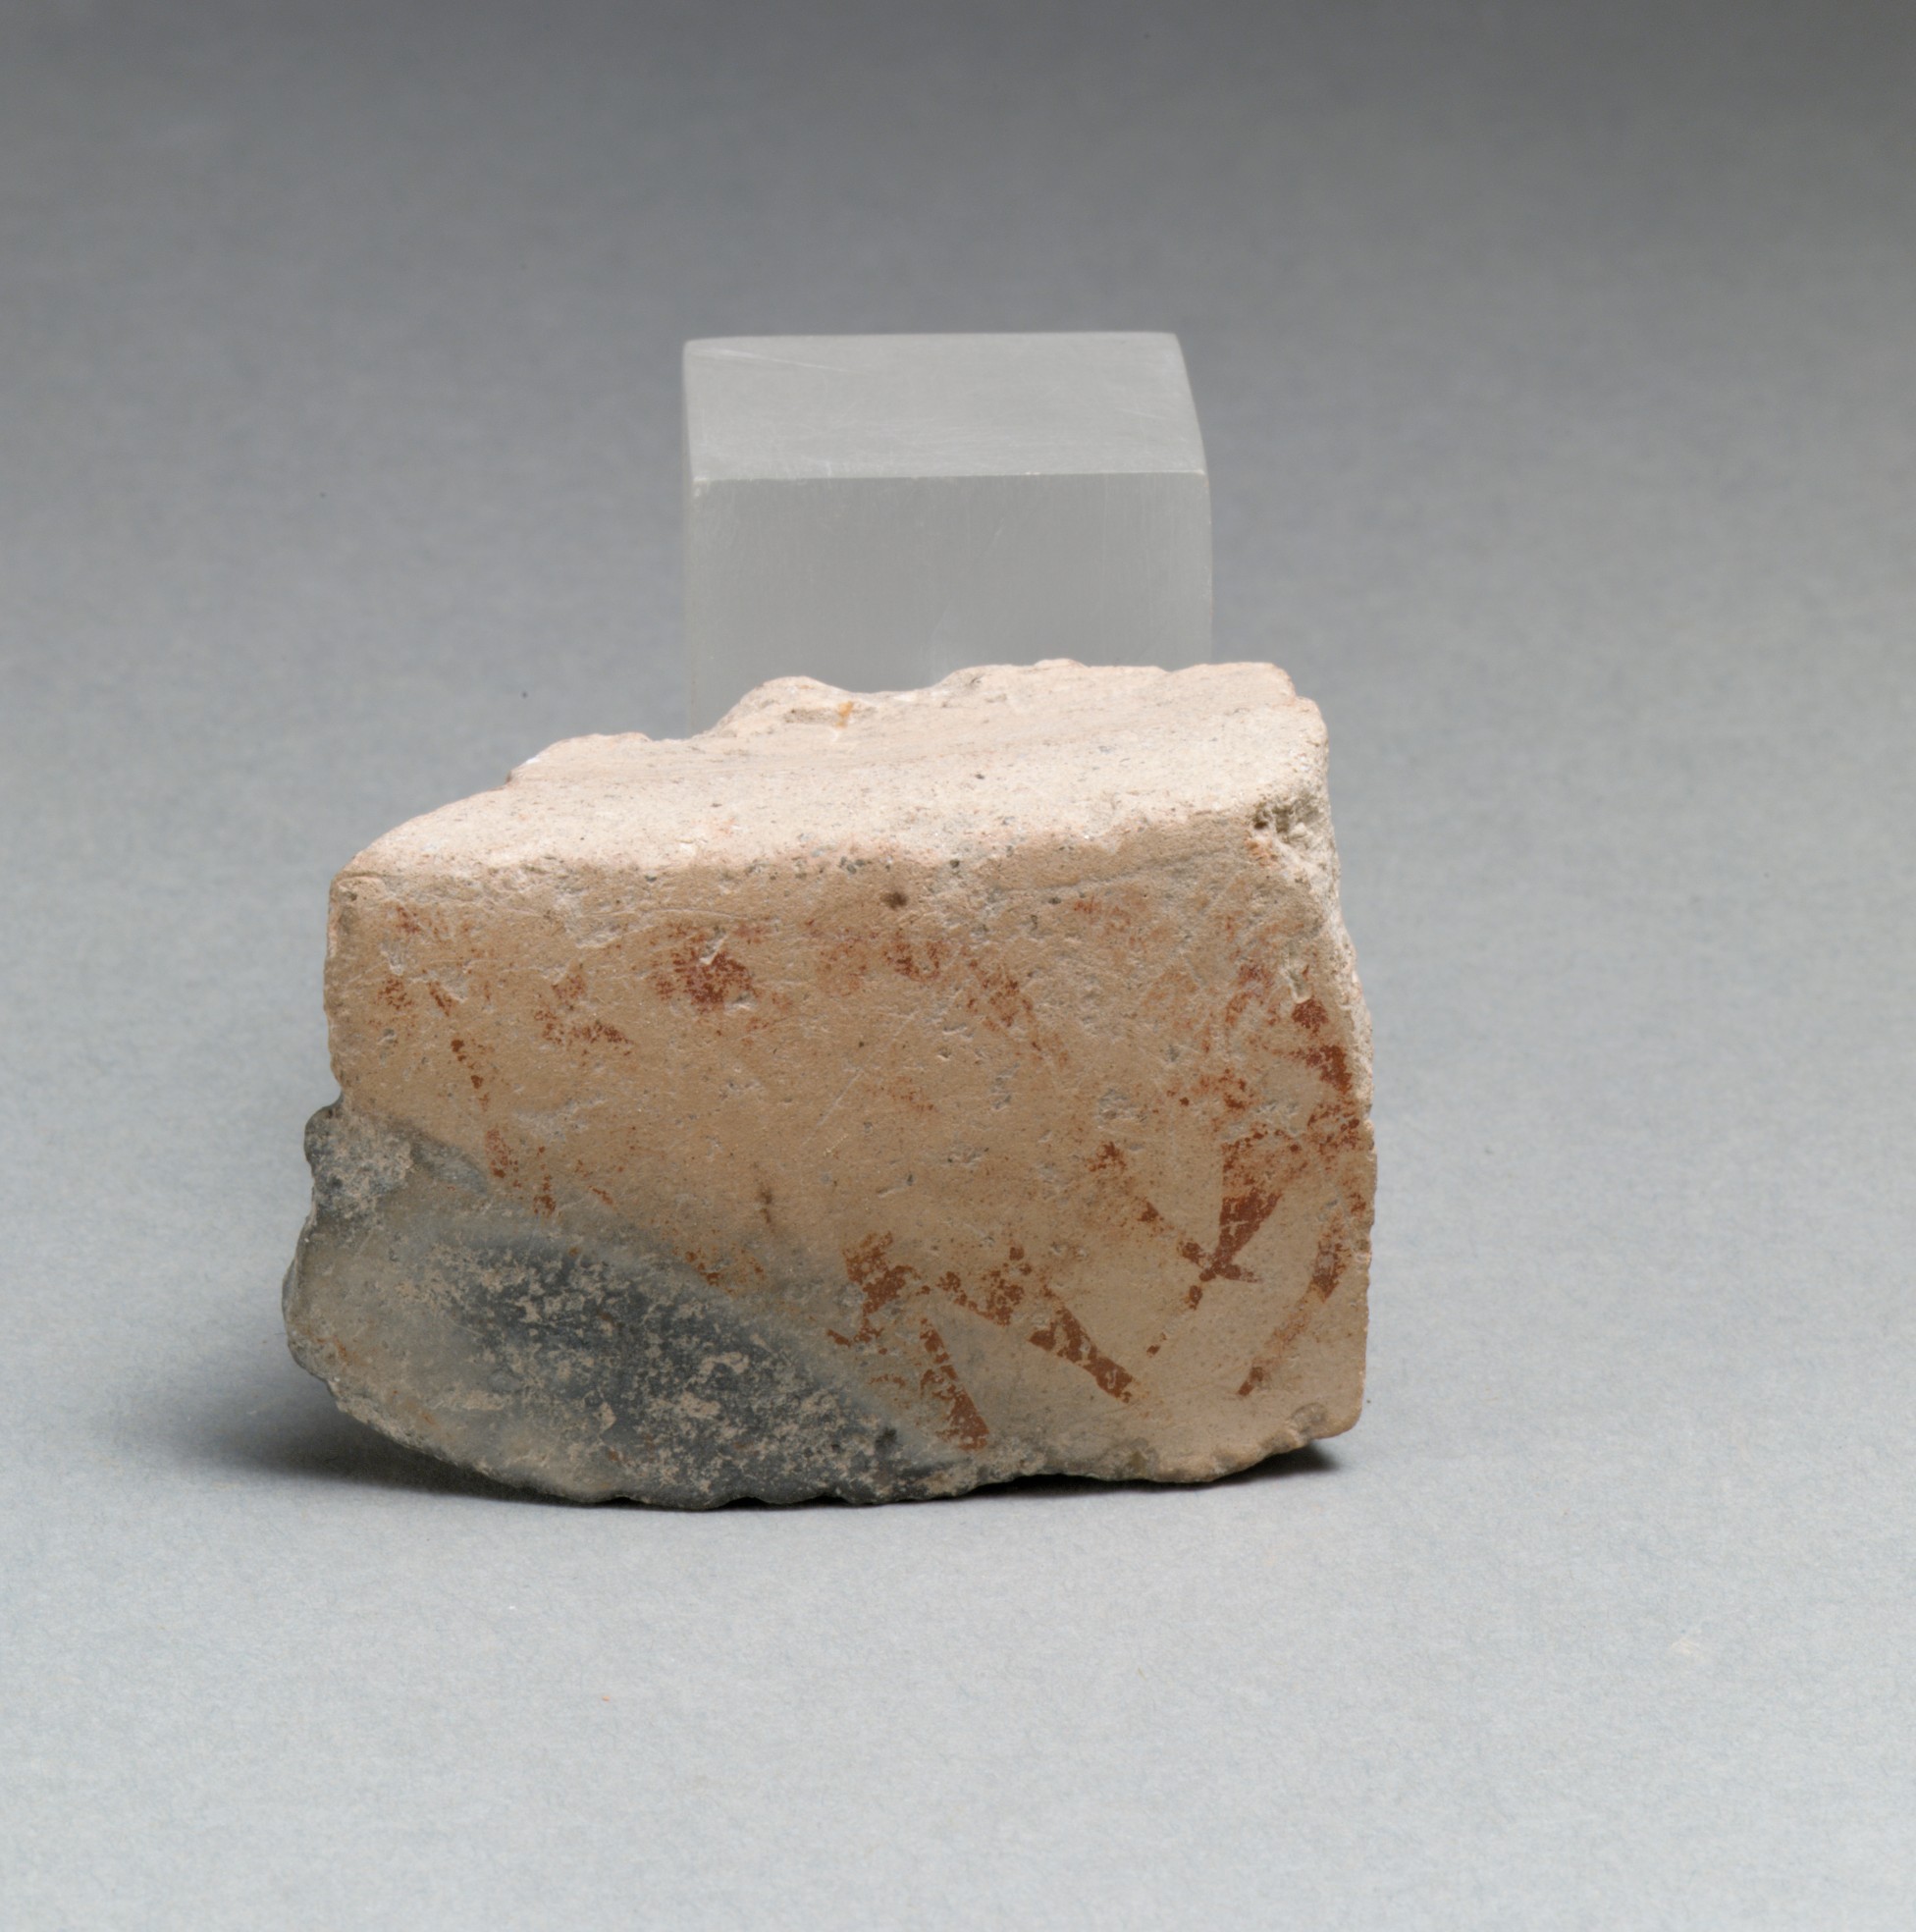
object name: vase fragment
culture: neolithic, thessaly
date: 6500-5800 BCE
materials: terracotta